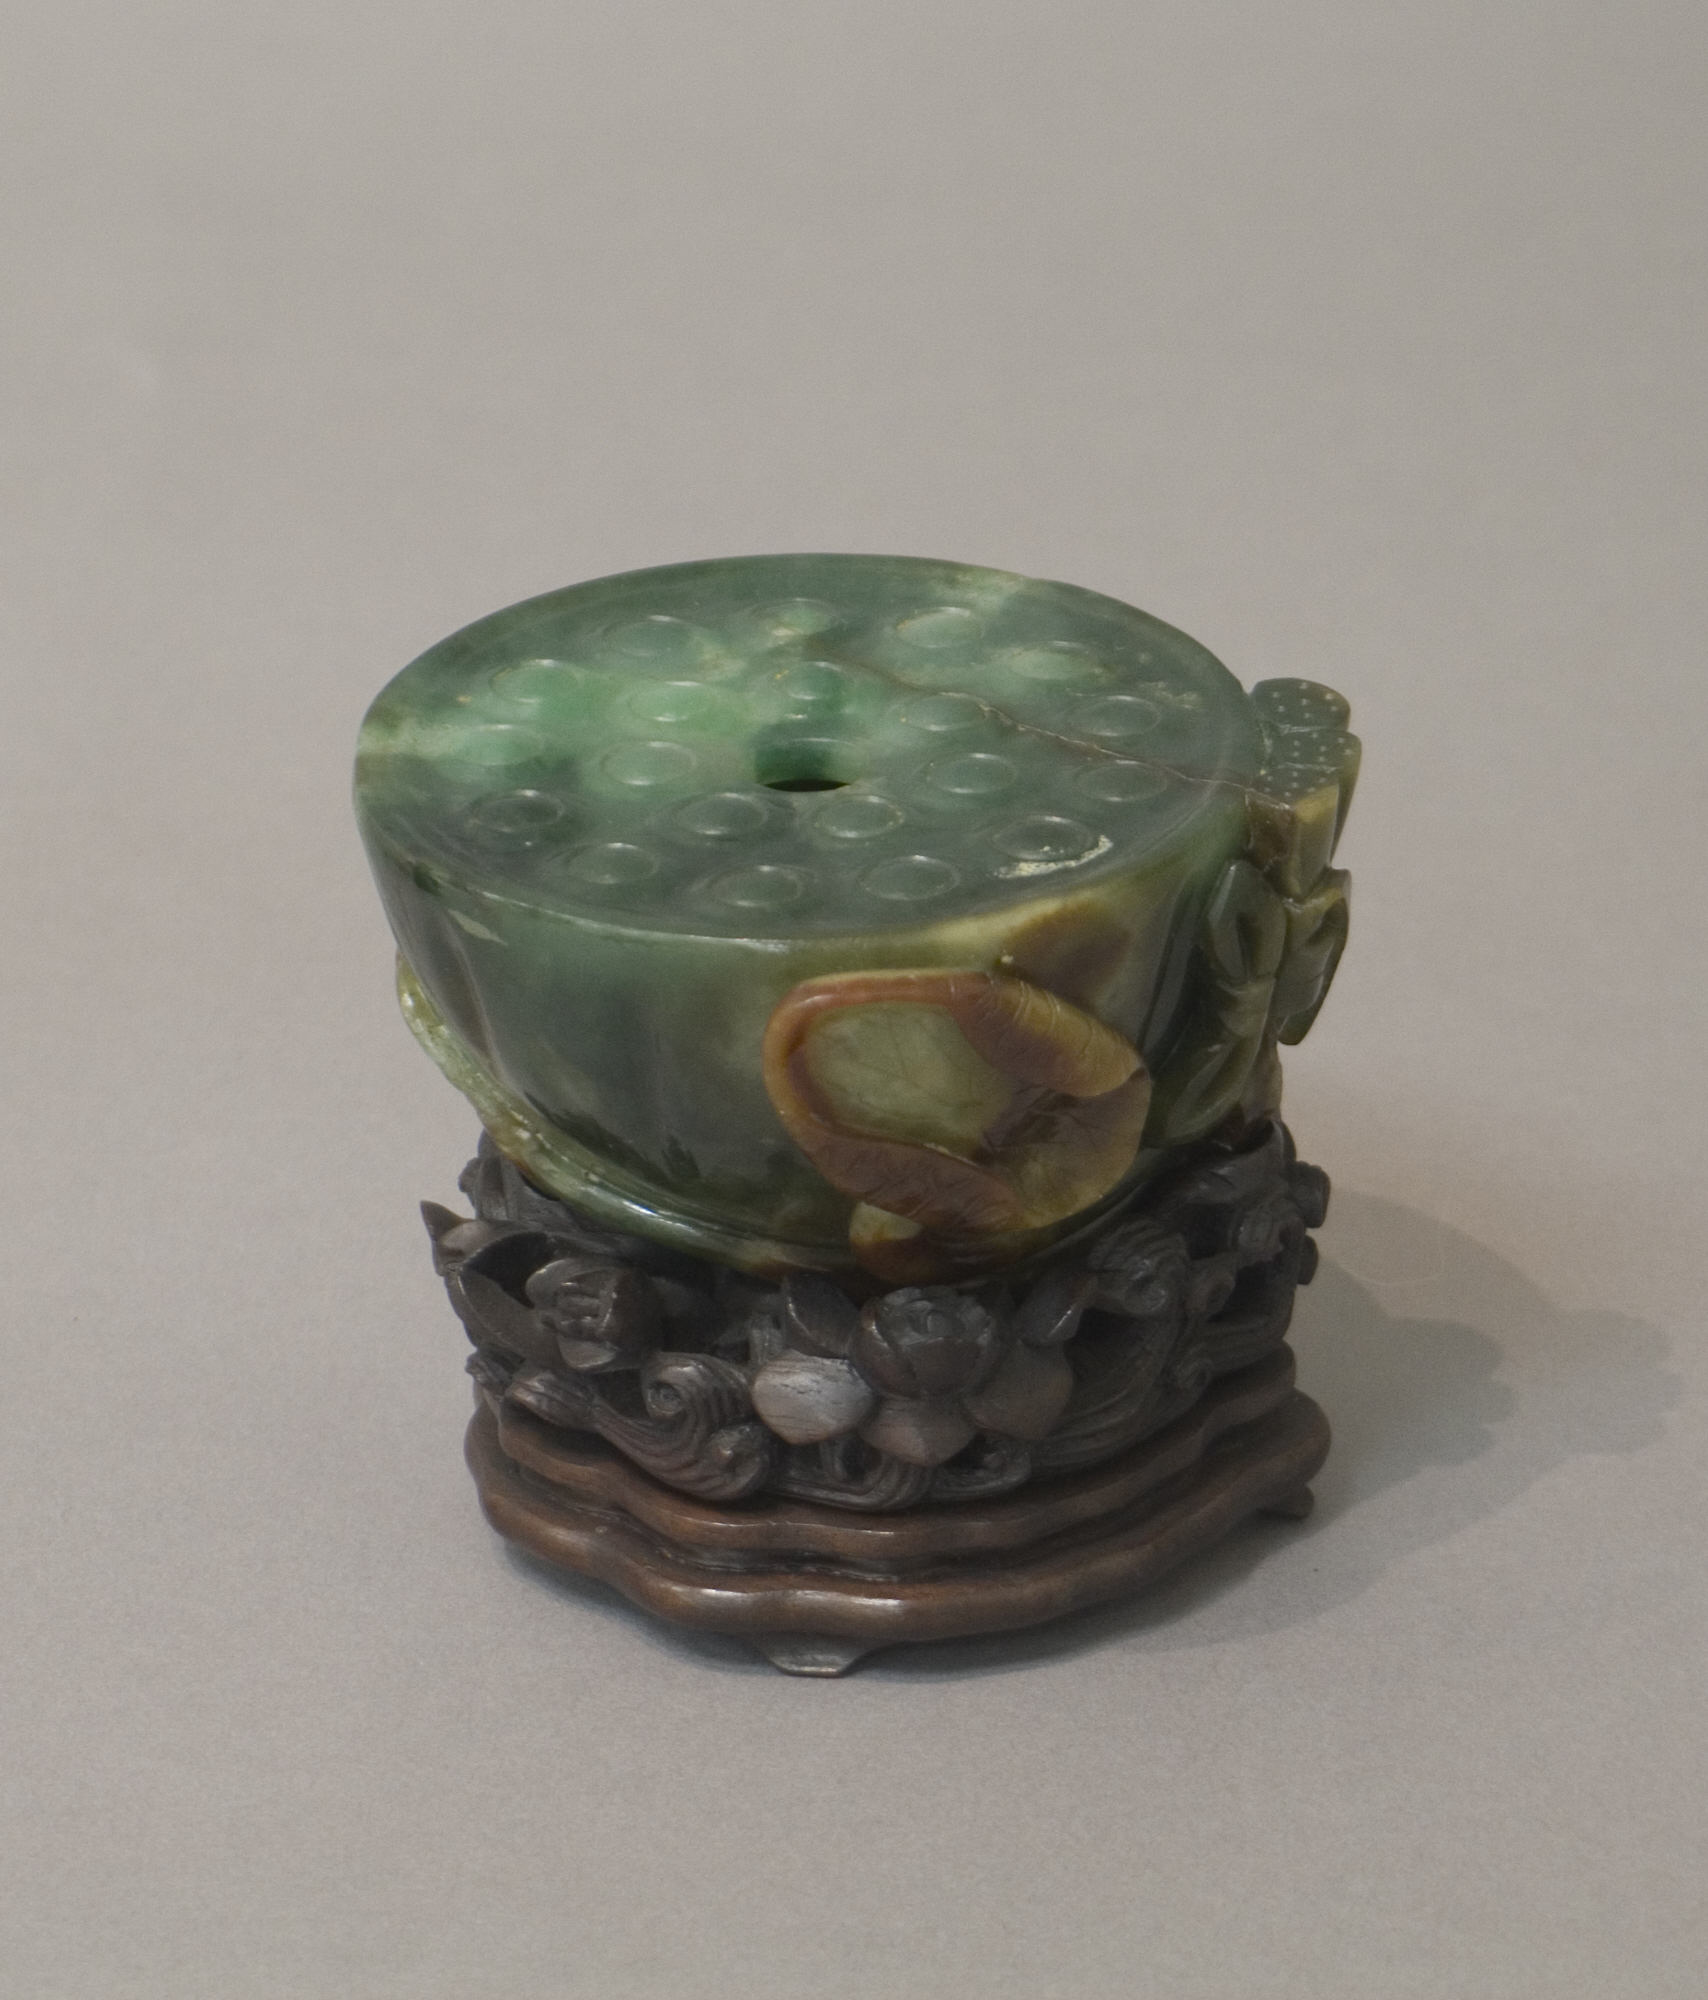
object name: artist's water holder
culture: chinese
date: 1662-1722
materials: jade, wood